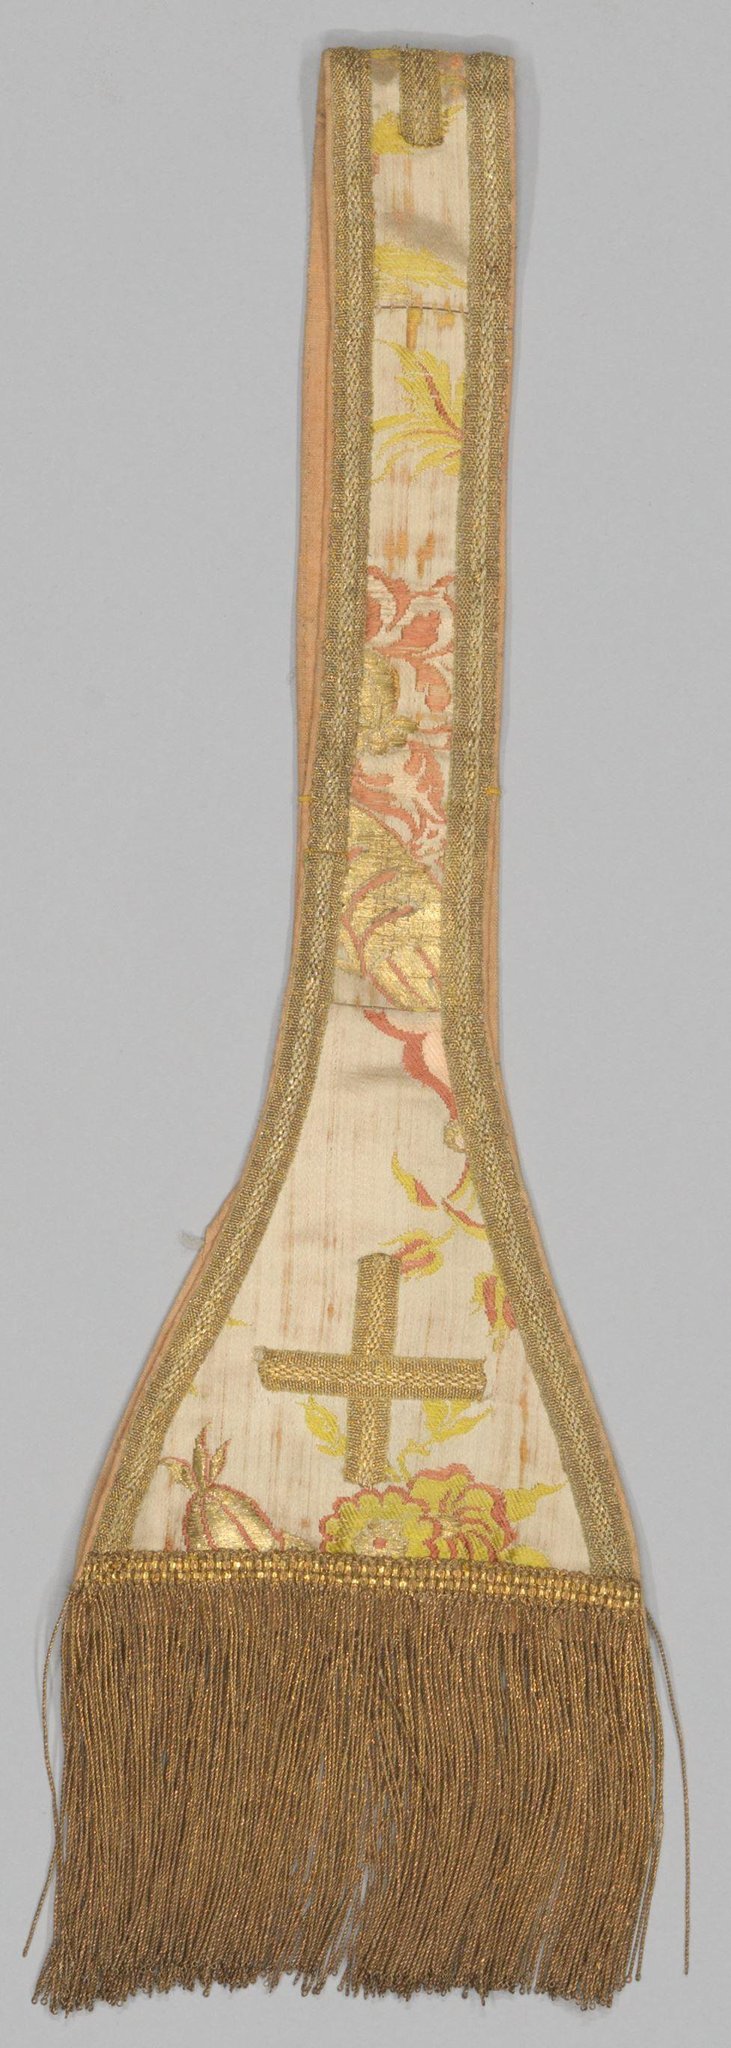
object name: maniple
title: Manipel van goudbrokaat met bloempatroon, z.g. "Bizar" ontwerp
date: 1706-1707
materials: silk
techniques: brocade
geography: france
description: Manipel van goudbrokaat met bloempatroon, z.g. "Bizar" ontwerp. Met aan weerzijden twee goudkleurige kruisen. Aan beide uiteinden lange goudkleurige franje.